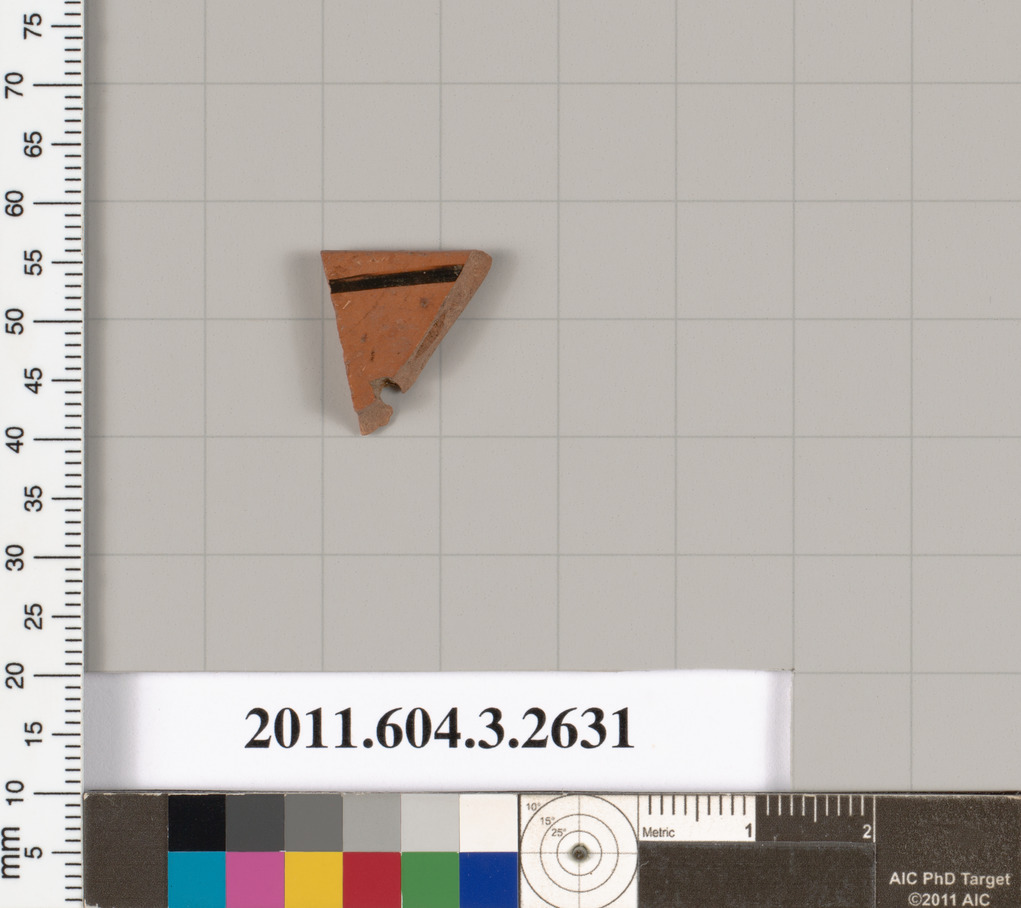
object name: kylix fragment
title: Terracotta rim fragment of a kylix (drinking cup)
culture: greek, attic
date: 600-401 BCE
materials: terracotta